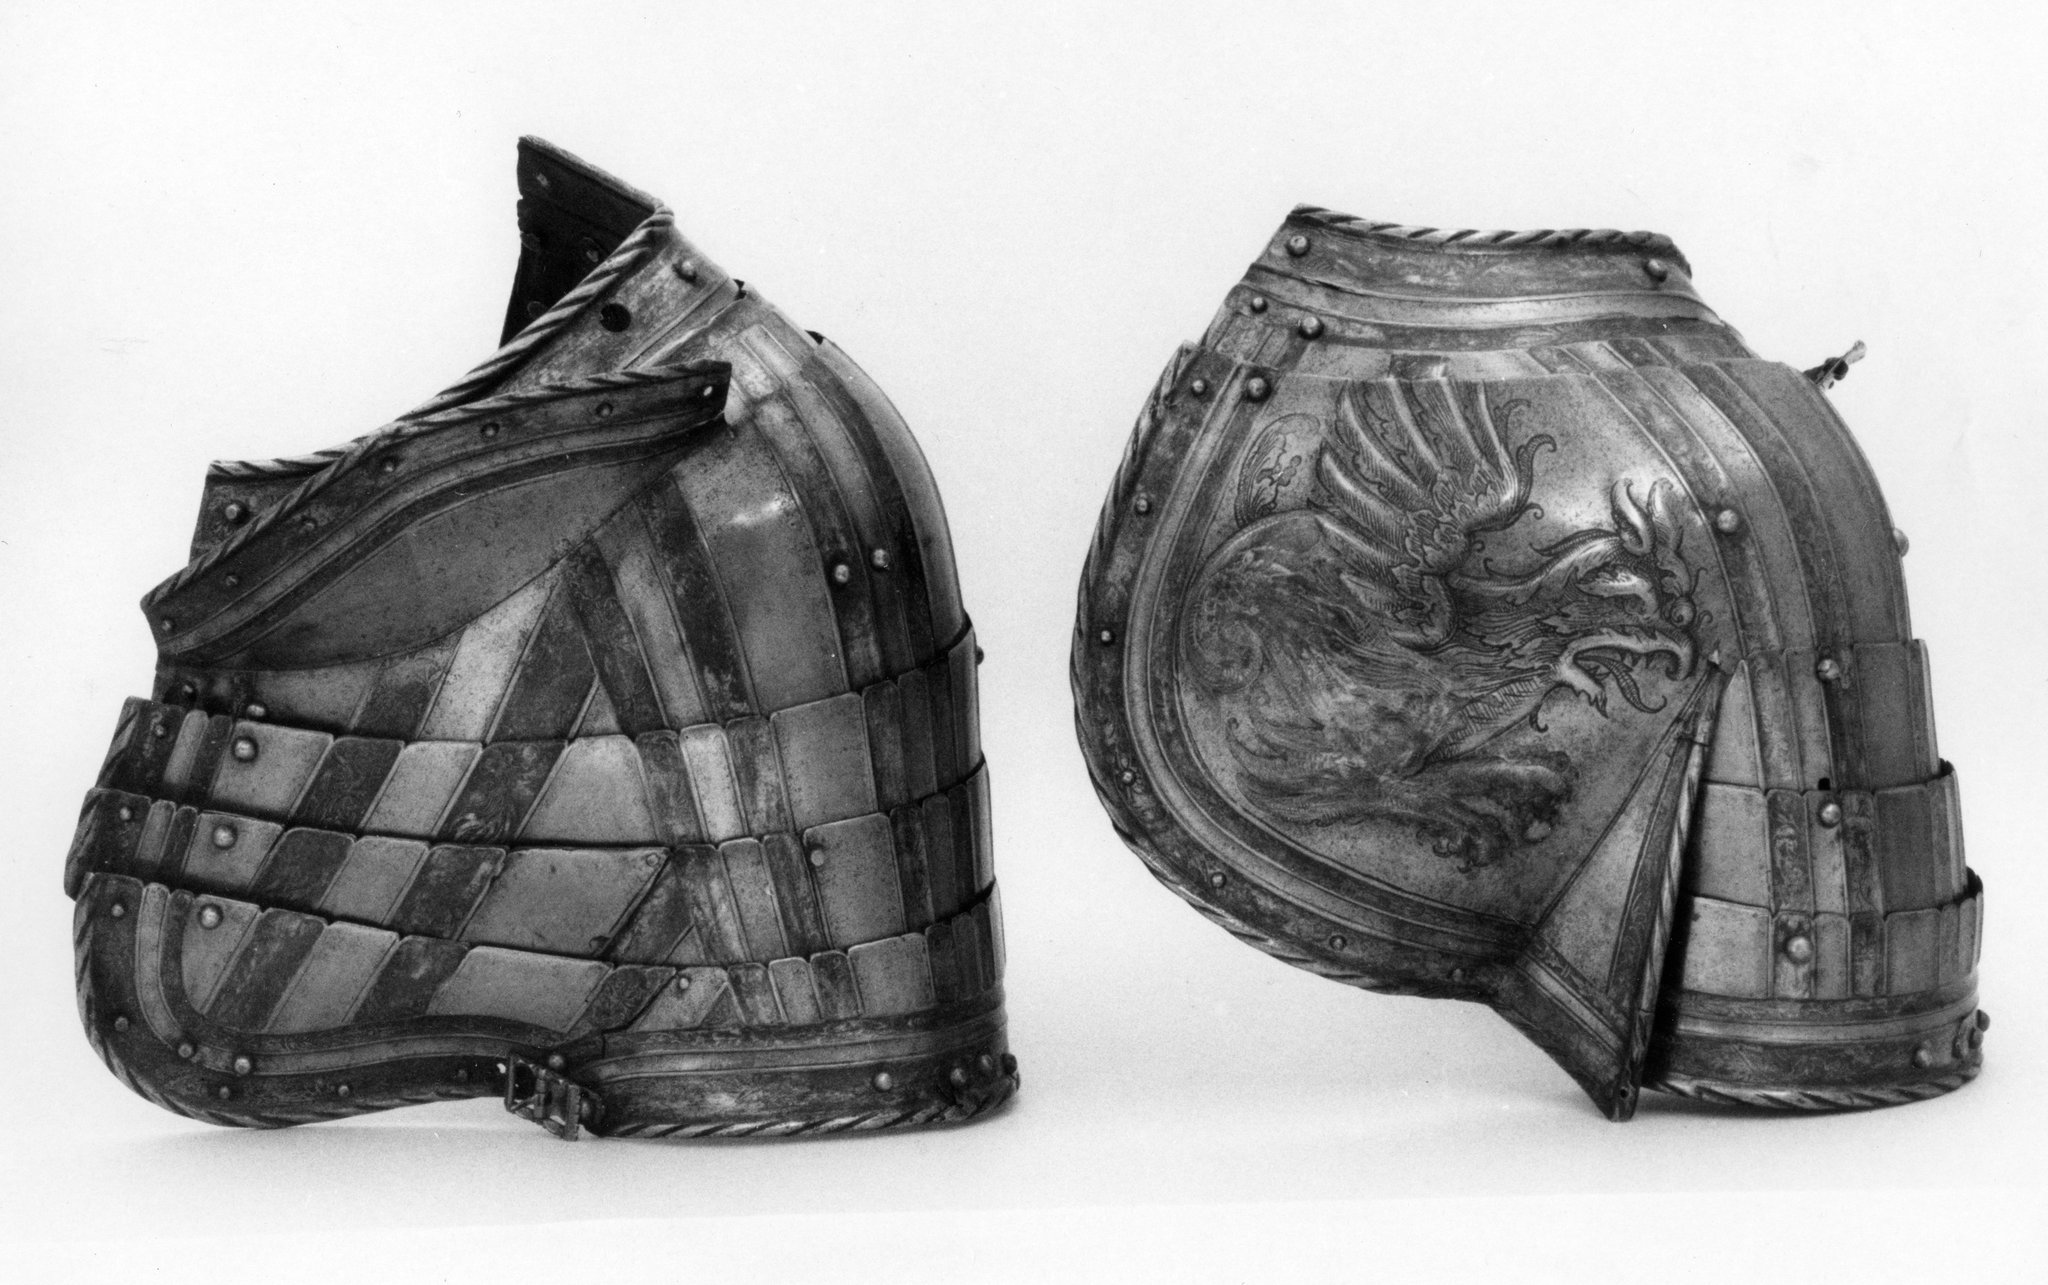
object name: pair of pauldrons shoulder defense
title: Pair of Pauldrons (Shoulder Defenses)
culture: german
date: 1550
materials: gold, steel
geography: germany